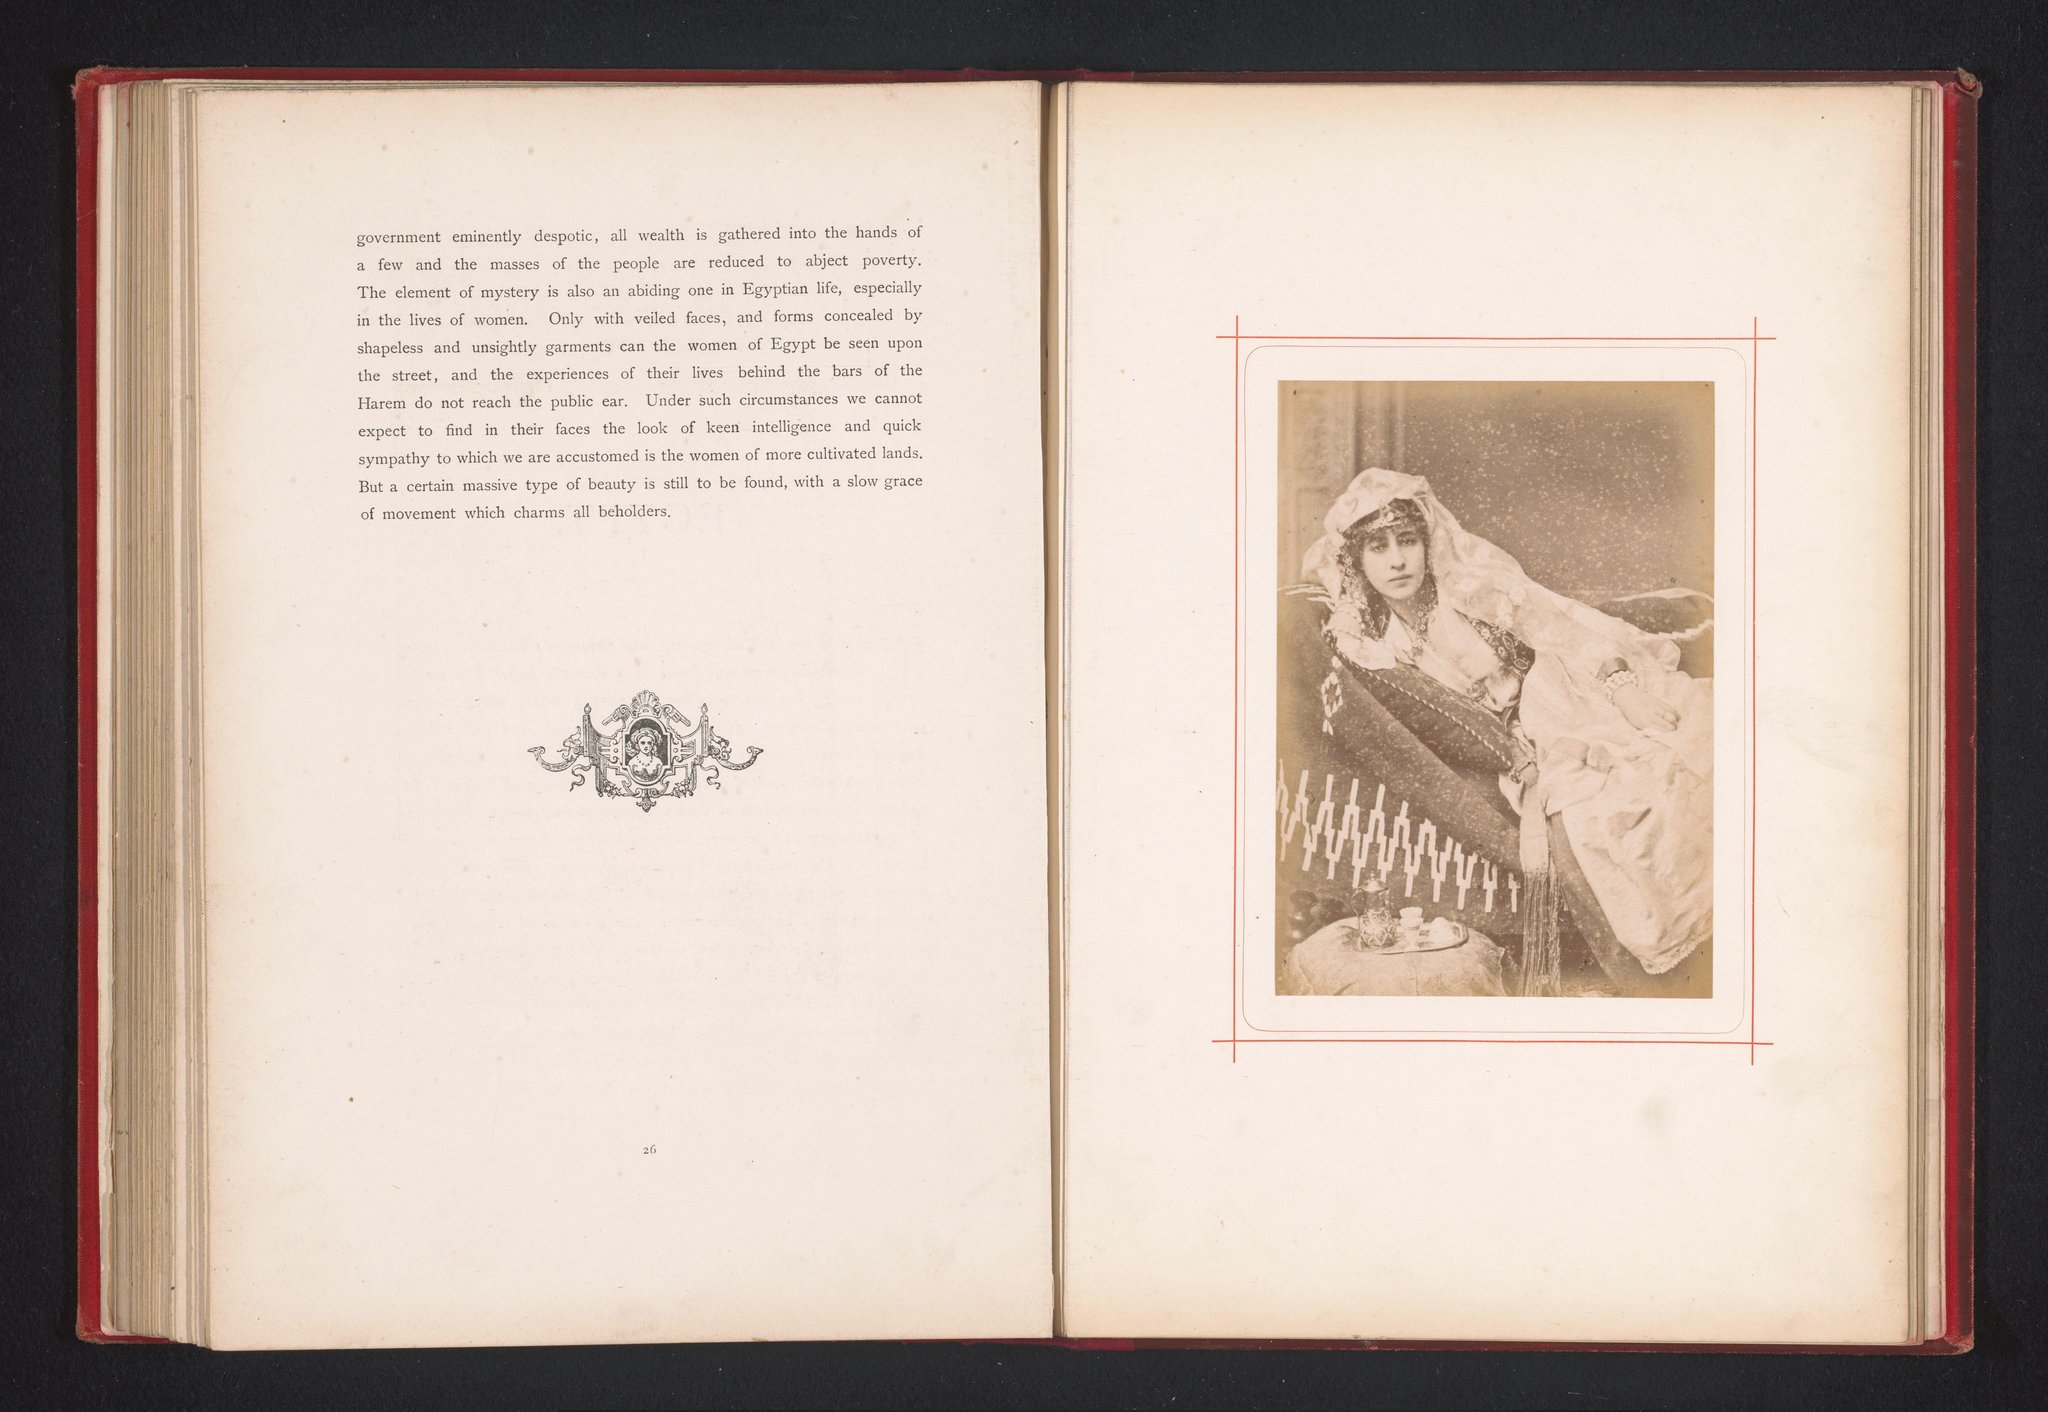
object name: photograph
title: Portret van een onbekende vrouw in klederdracht uit Turkije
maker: Anonymous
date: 1876-1886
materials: photographic support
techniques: albumen print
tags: folk costume, regional costume, tea- and coffee-service, anonymous historical person portrayed - bb - woman